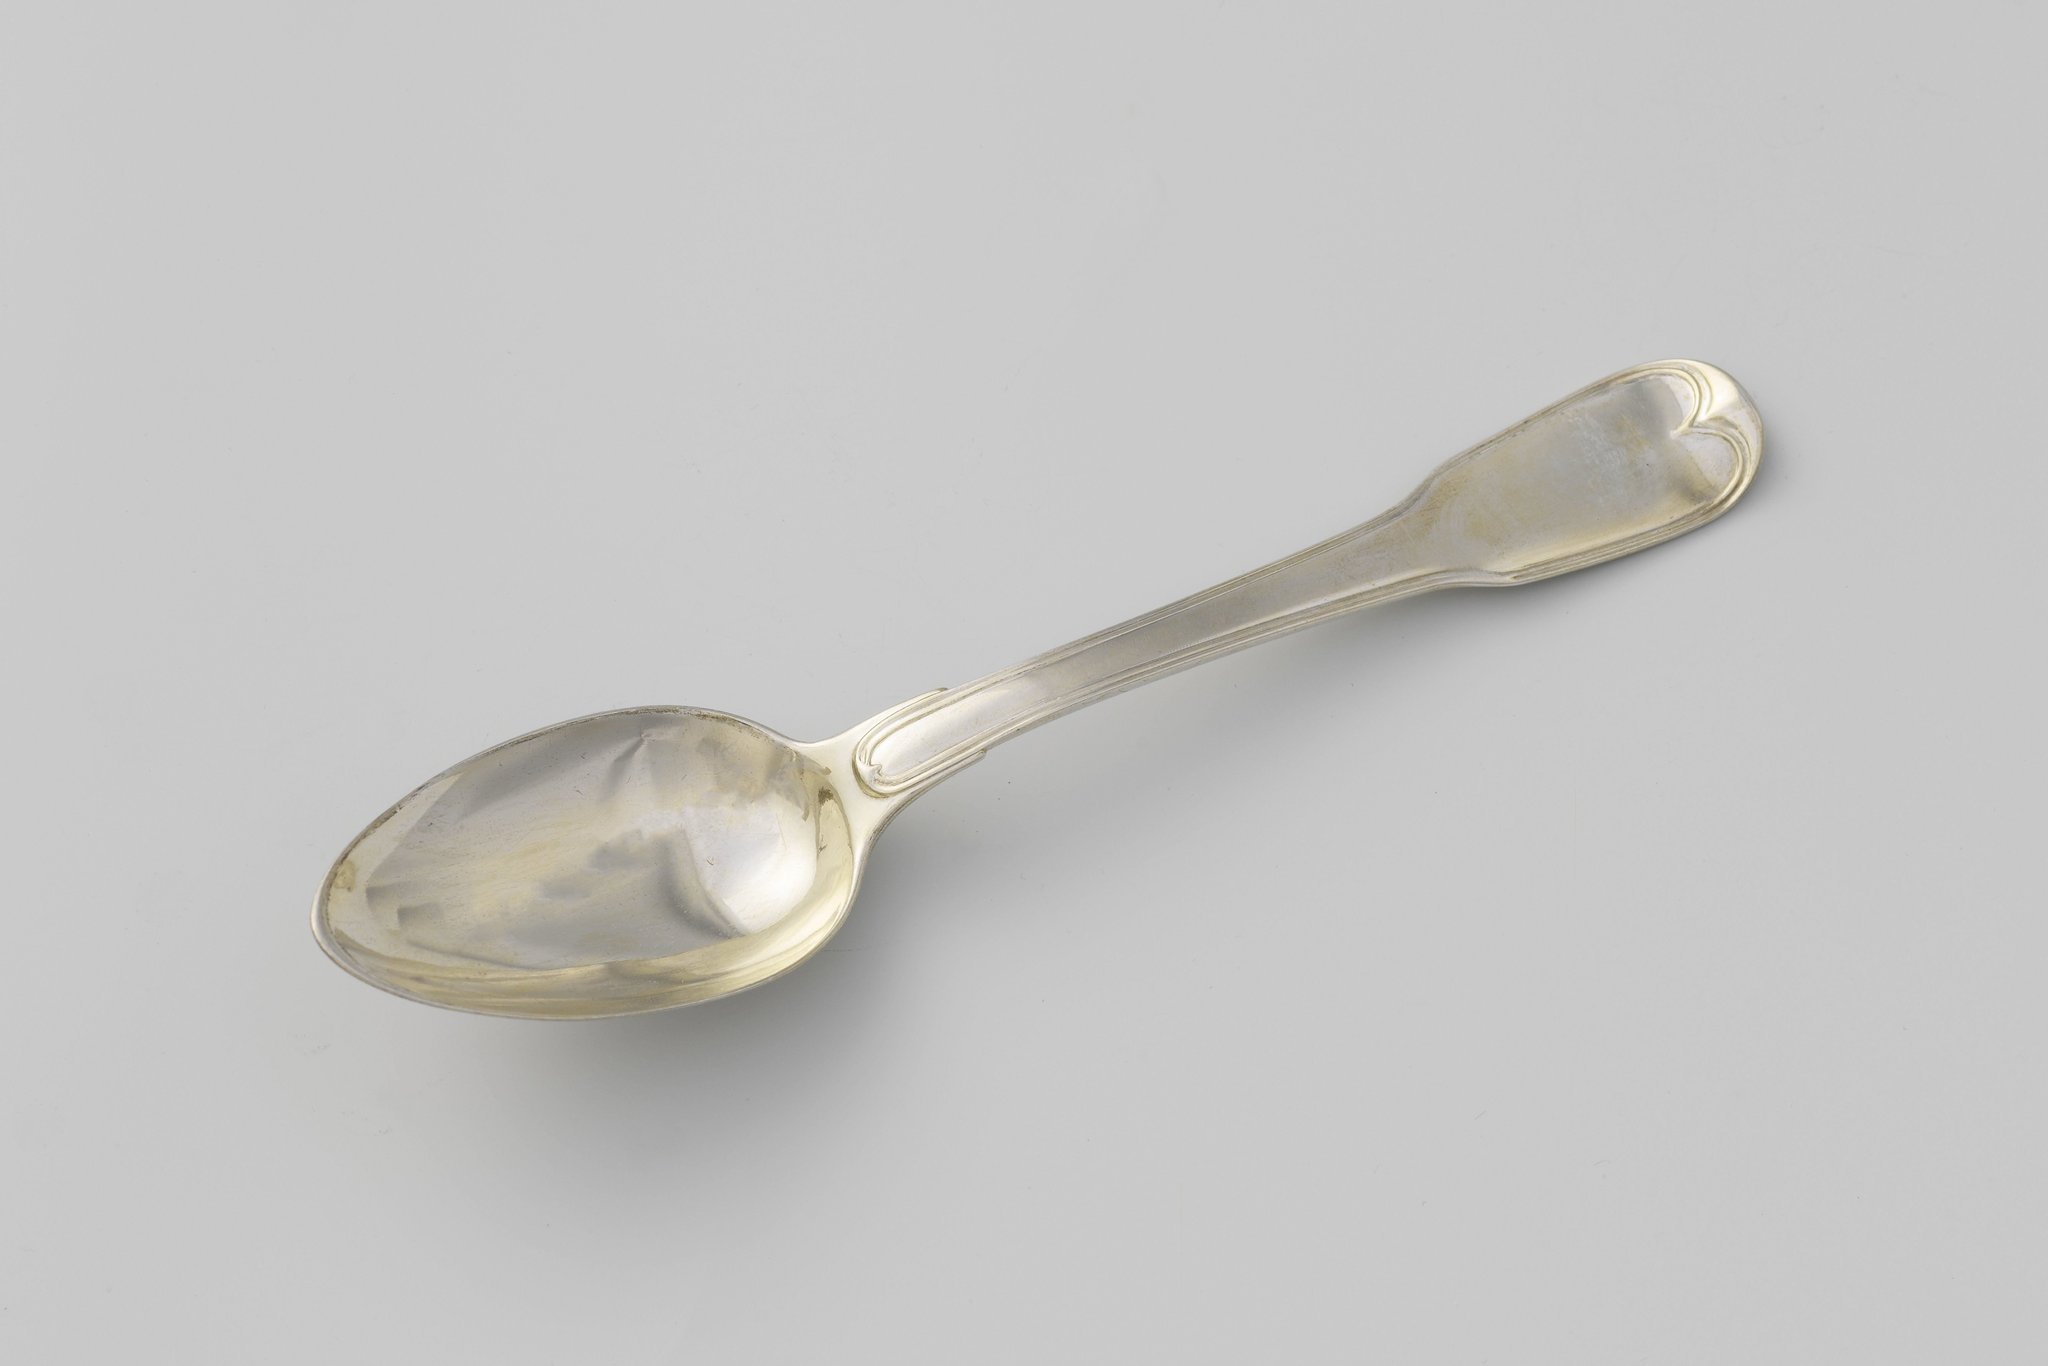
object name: spoon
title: Lepel met het helmteken Clifford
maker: roelof helweg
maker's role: silversmith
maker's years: 1758-1843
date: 1806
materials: silver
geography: amsterdam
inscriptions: alloy mark: ‘Hollandse leeuw’, maker's mark: ‘RH in ovaal’, town mark: ‘Amsterdam’, date letter: ‘X (=1806)’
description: De eivormige bak van de lepel is aan zowel boven- als onderzijde door middel van enkel lof verbonden met de platte, gebogen steel, die zich verbreedt naar het spatelvormige uiteinde. Boven- en onderzijde van de steel worden omgeven door een dubbele filetrand, die bij het uiteinde ingezwenkt is. Op de onderzijde van de spatel is het helmteken Clifford gegraveerd.